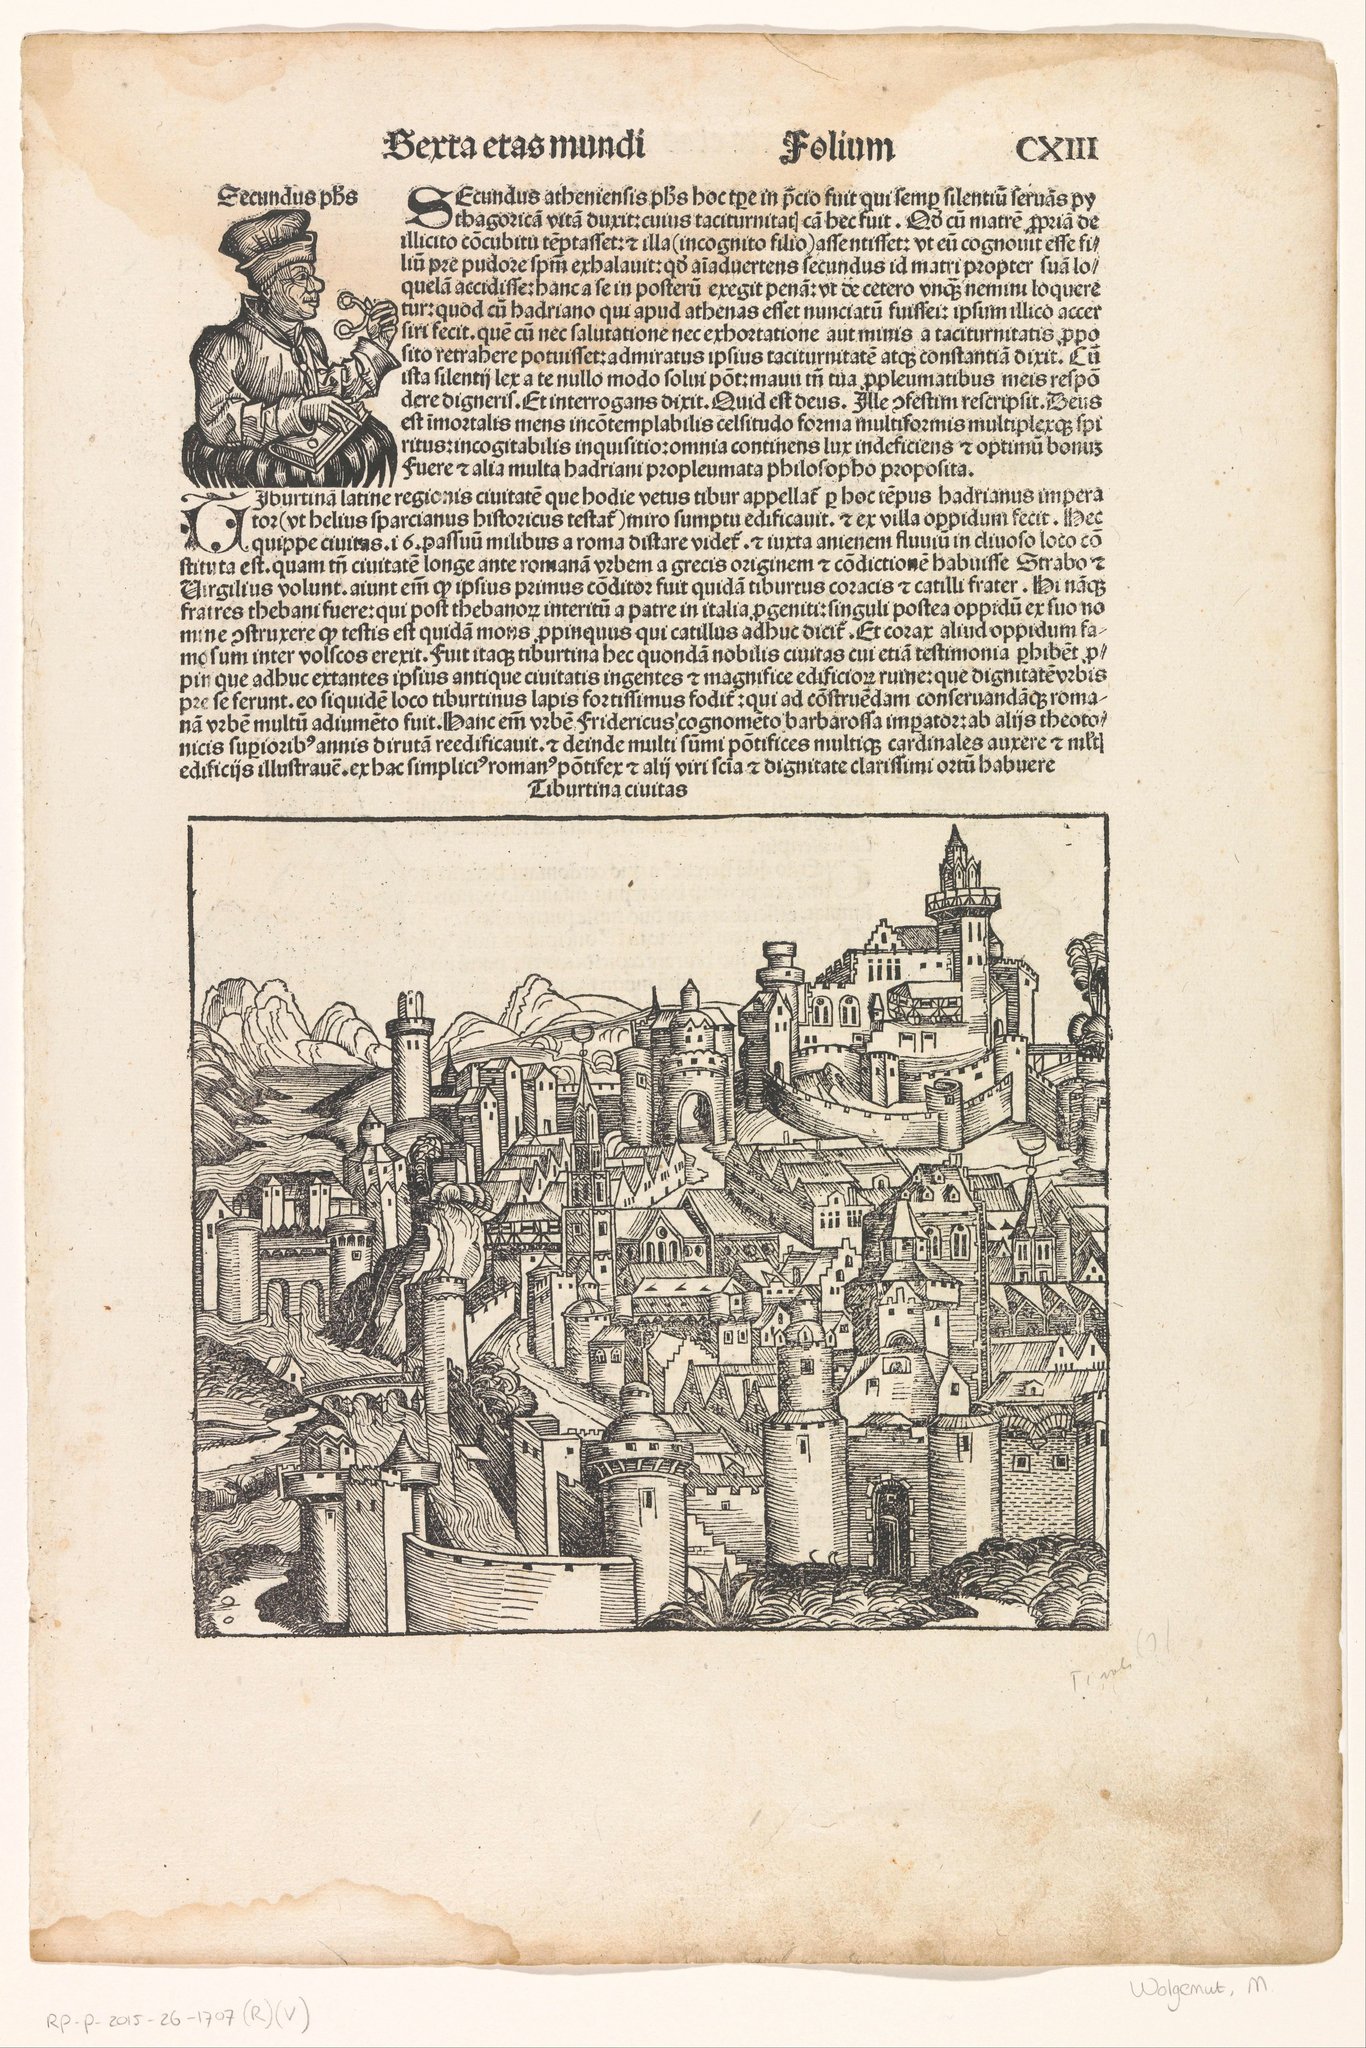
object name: page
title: Bladzijde uit de Neurenbergkroniek van Schedel, folio 113r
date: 1493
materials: paper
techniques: letterpress printing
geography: nuremberg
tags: eyeglasses, spectacles, city-view, and landscape with man-made constructions, scholar, philosopher, tivoli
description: De Neurenbergkroniek van Hartmann Schedel is bekend om zijn vele illustraties. Voor de 1804 houtsneden werden 441 verschillende houtblokken gemaakt. Vele houtblokken werden dus meer dan eens gebruikt. Titels bij de figuren identificeren de voorstelling of de voorgestelde personen. Deze pagina is afkomstig uit de Latijnse uitgave van 1493.